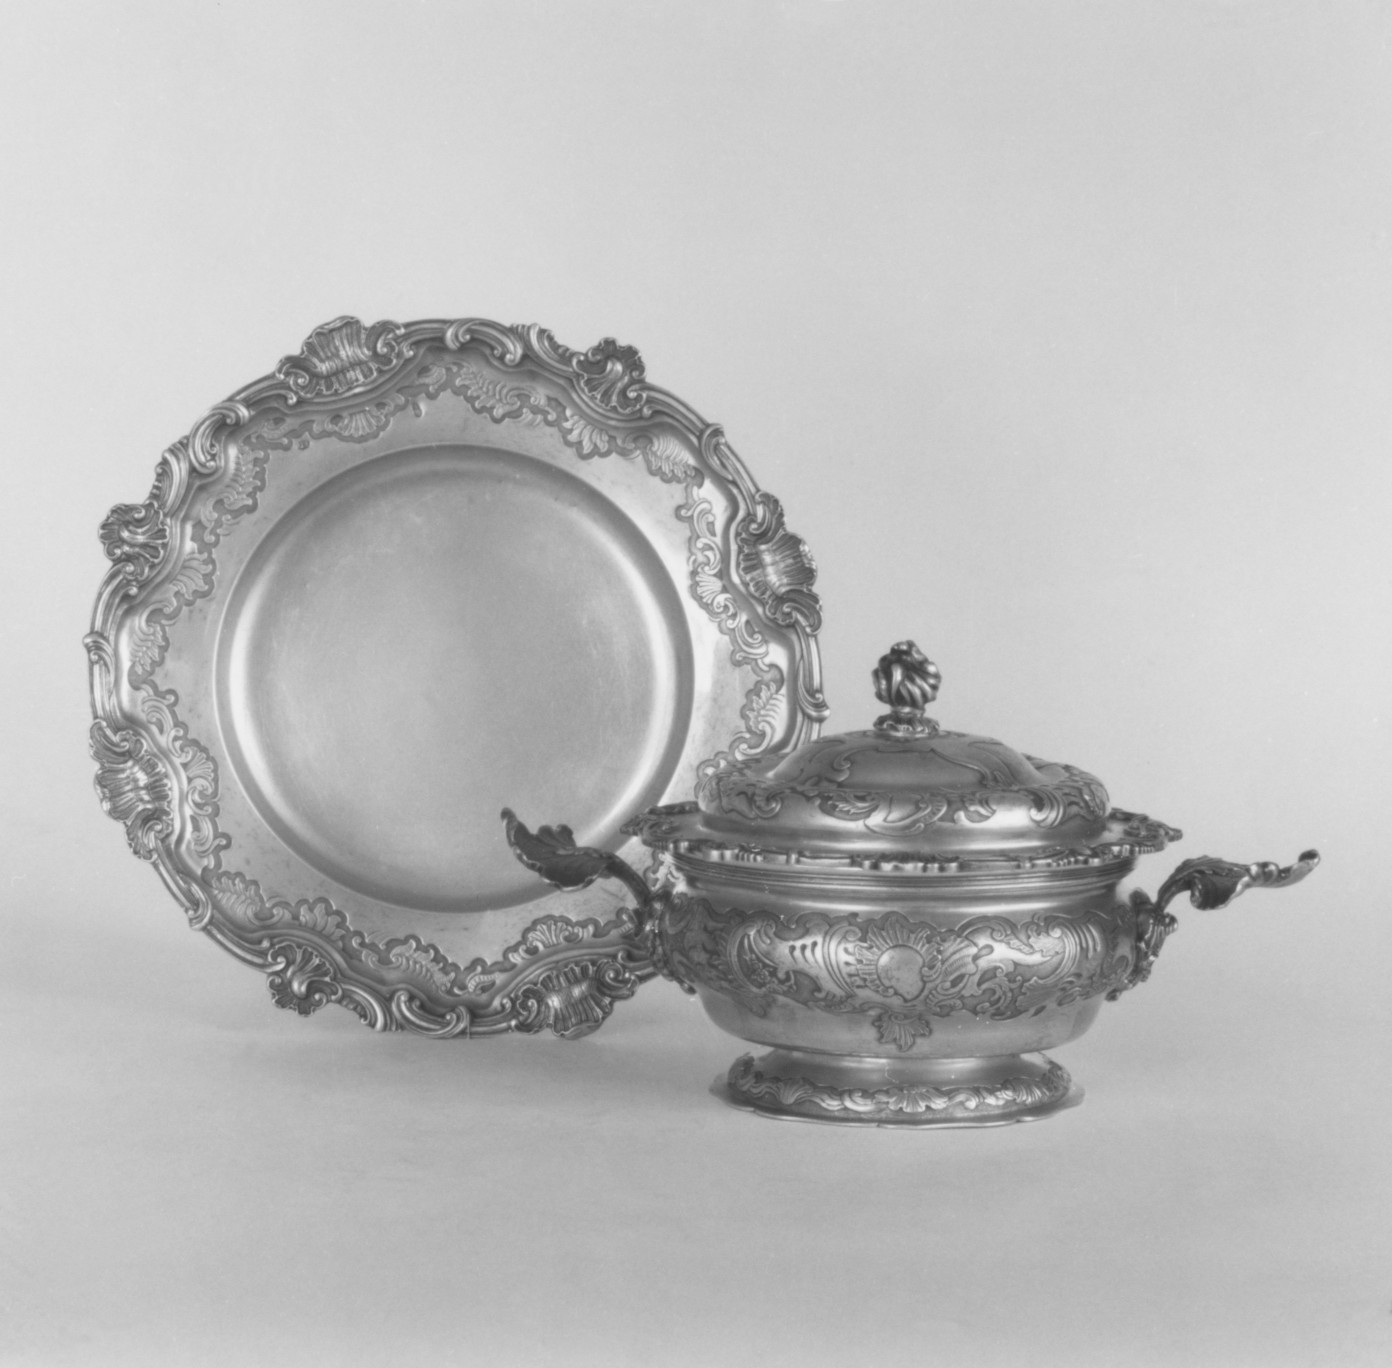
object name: bowl with cover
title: Bowl with cover (écuelle)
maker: emanuel drentwett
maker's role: maker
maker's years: 1681-1753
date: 1743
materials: silver gilt